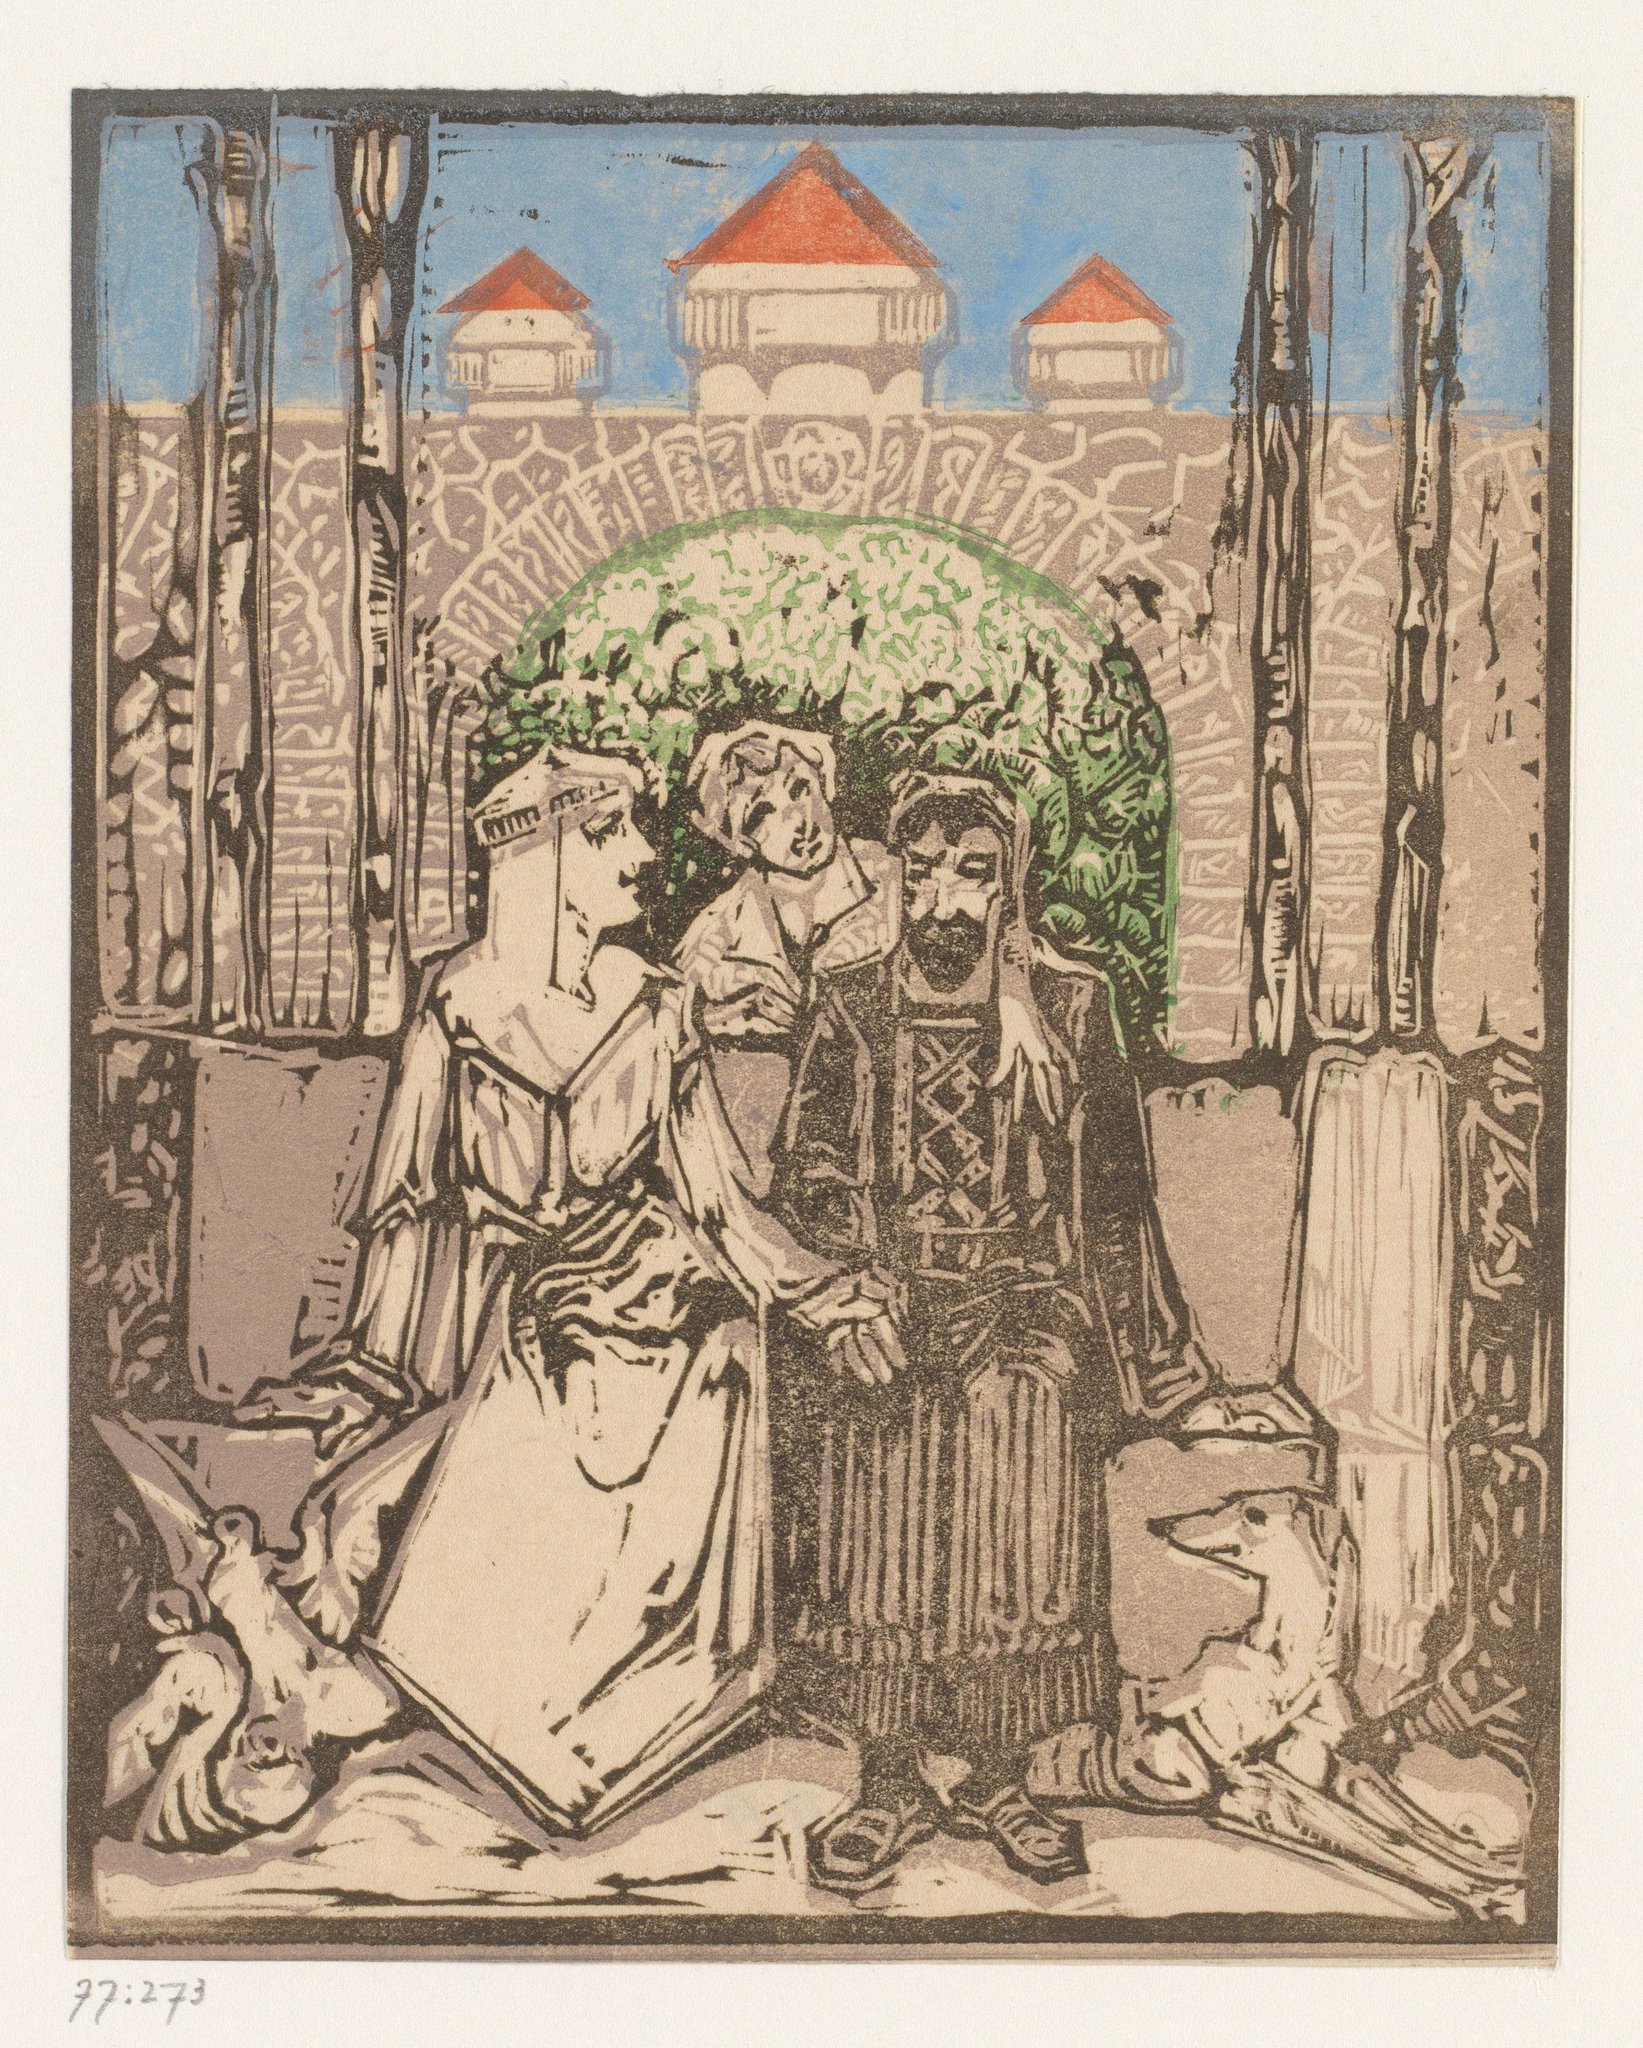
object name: print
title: Zittend paar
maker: bernard willem wierink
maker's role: draughtsman, print maker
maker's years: 1856-1939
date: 1938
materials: paper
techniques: relief print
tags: other birds: dove, couple of lovers, dog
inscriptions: collector's mark: Lugt 2228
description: Illustratie voor een uitgave van een onbekend toneelstuk. Deze prent is waarschijnlijk een plaatsnede, ook al wordt in de literatuur veelal gesproken over een houtsnede. Voor zover Wierink zijn prenten in hoogdruk zelf heeft omschreven, heeft hij altijd de term 'plaatsnede' gebruikt.